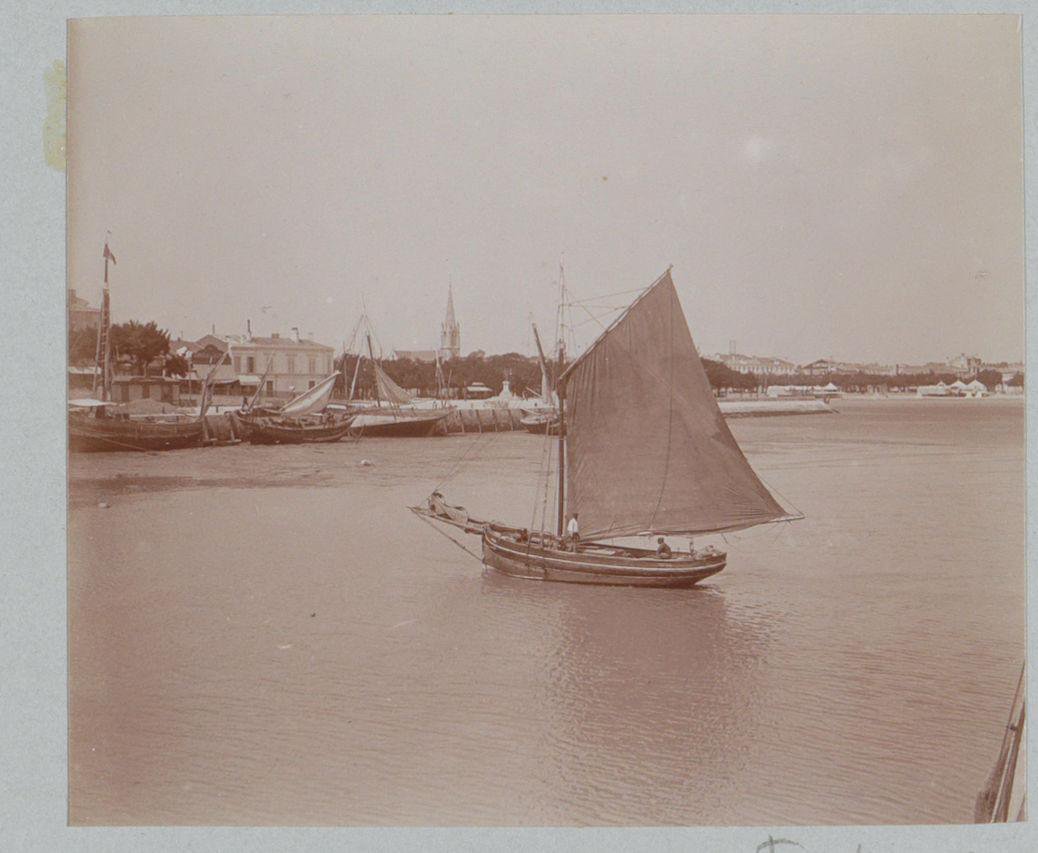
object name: photograph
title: Zeilboten in een haven in Frankrijk met op de achtergrond een kerktoren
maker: Anonymous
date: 1905-1910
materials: paper, photographic support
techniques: gelatin silver print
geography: france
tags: sailing-ship, sailing-boat, harbour (+ view ~ vehicle, ship, etc.), exterior ~ representation of a building, parts of church exterior and annexes: tower, france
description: Onderdeel van Fotoalbum van een Franse amateurfotograaf met bezienswaardigheden in Frankrijk, Zwitserland en Italië.